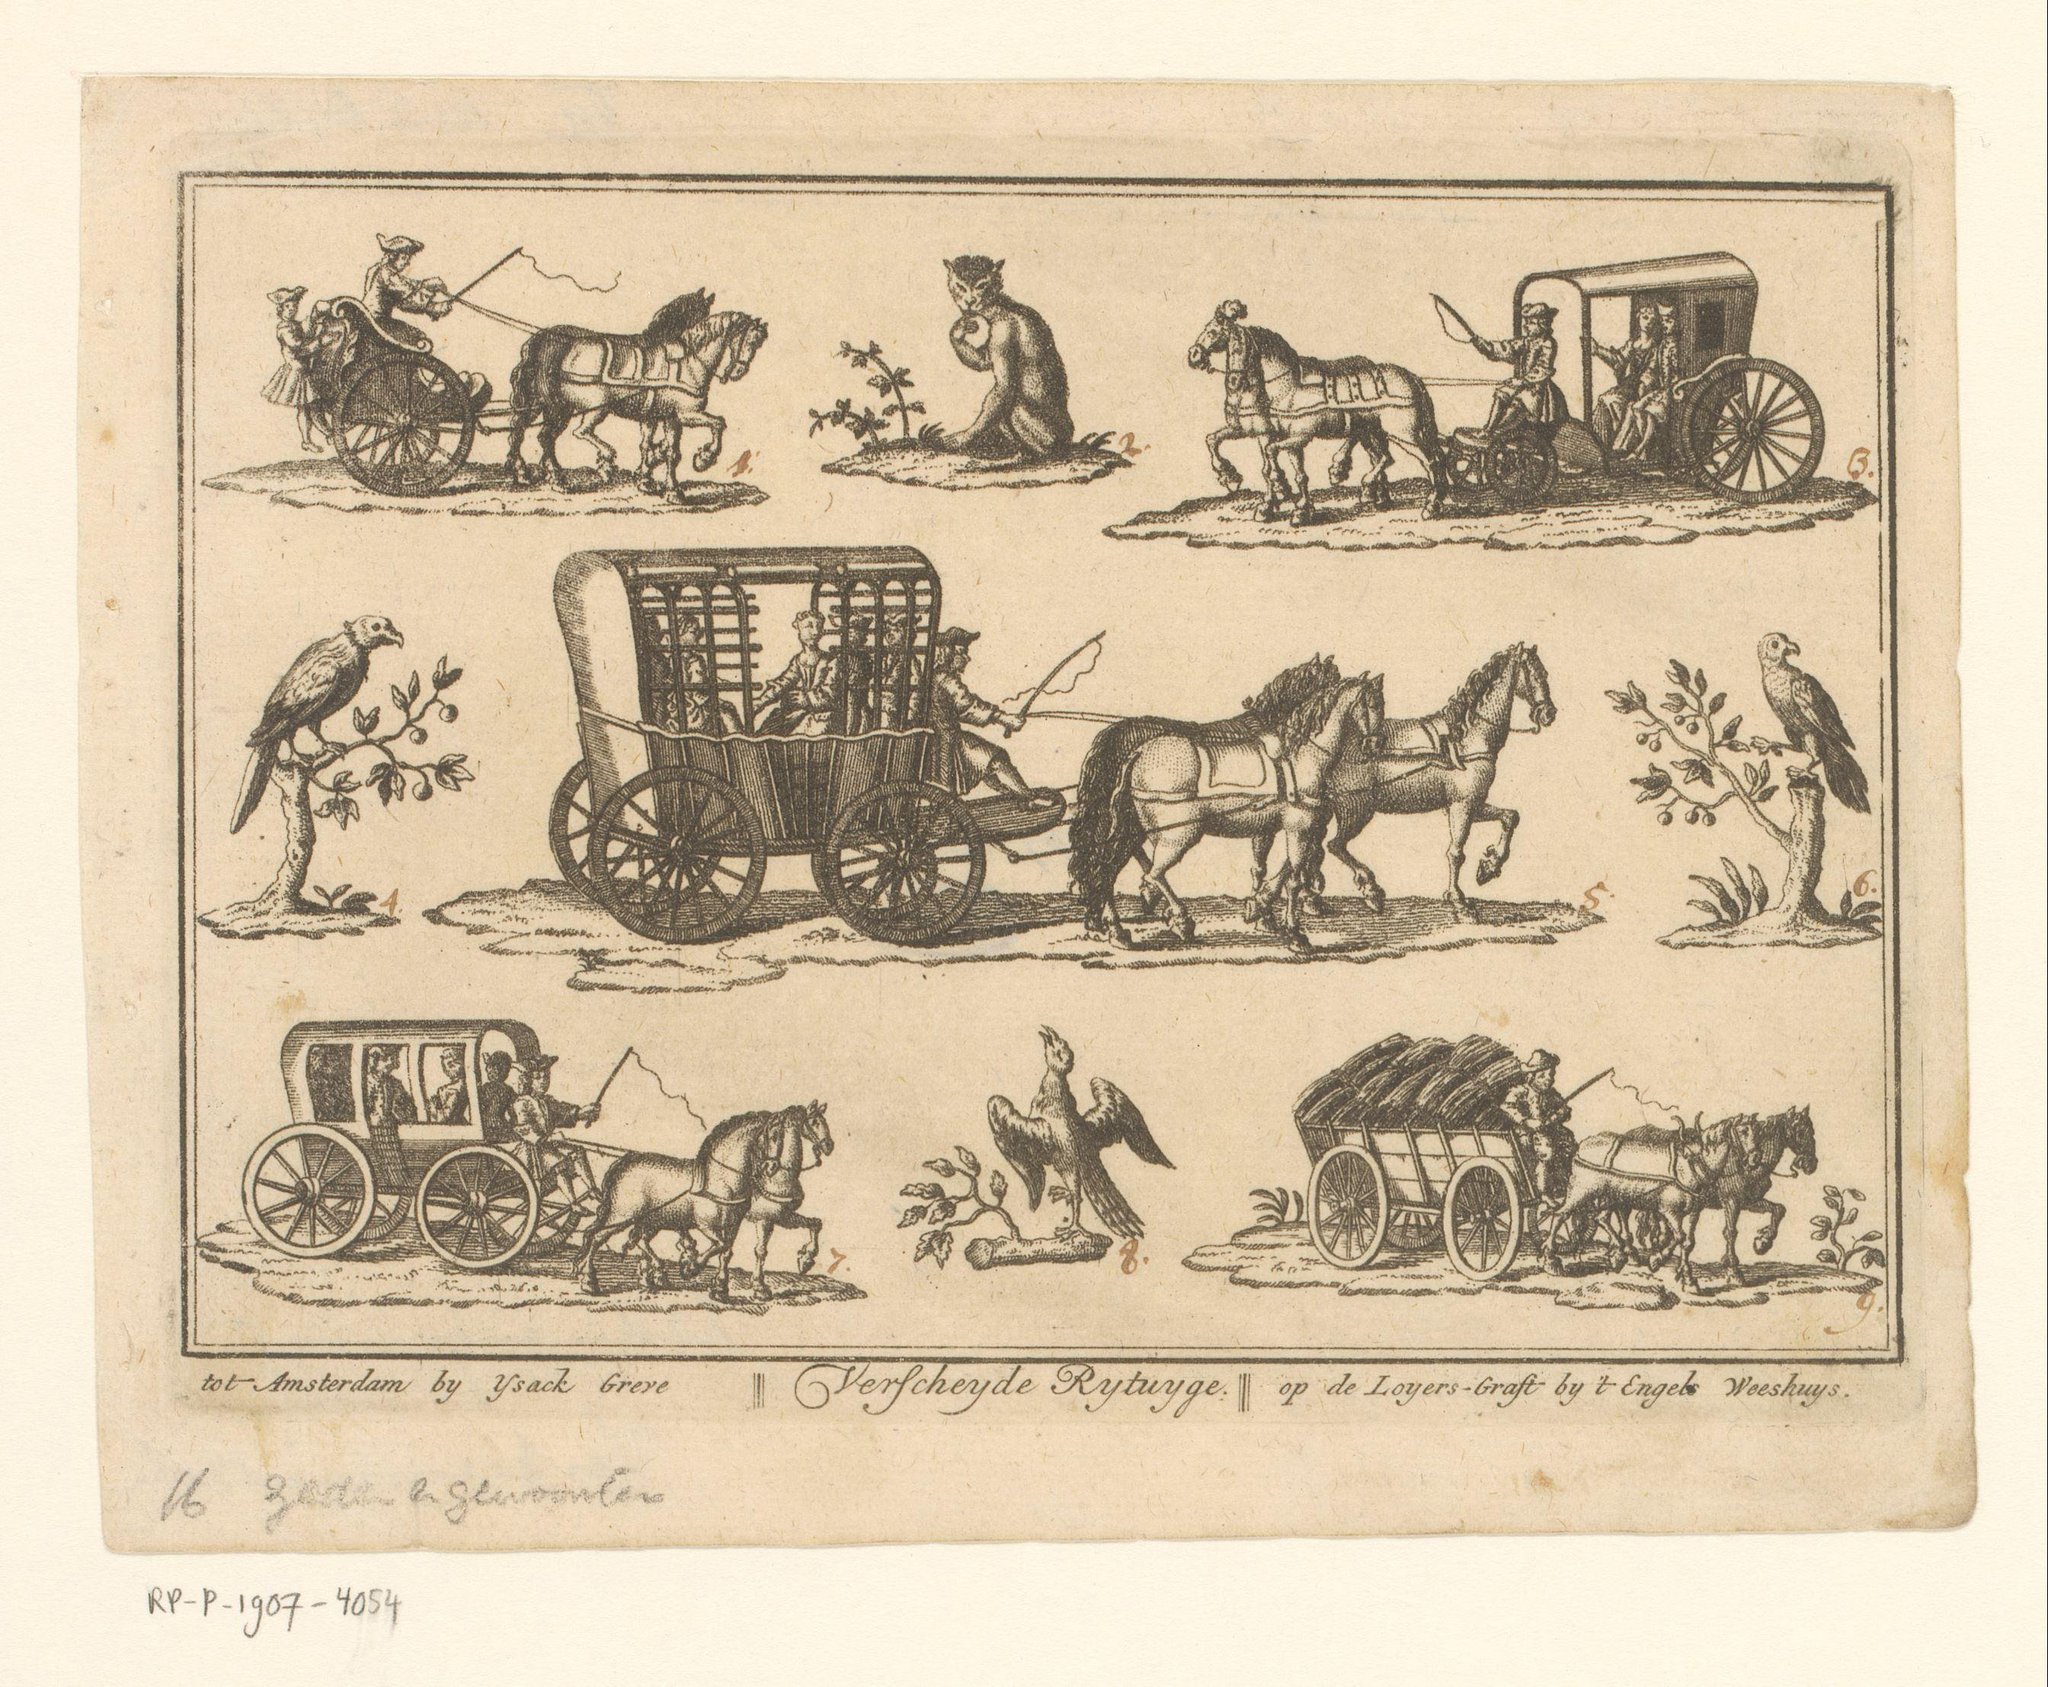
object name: print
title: Verschillende rijtuigen en vogels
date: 1718-1757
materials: paper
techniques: etching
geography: amsterdam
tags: monkeys, apes, birds, covered wagon, hooded wagon, four-wheeled vehicle drawn by two animals, hay-wagon, (farm) wagon, freight wagon, cart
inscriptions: collector's mark: Lugt 2228, number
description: Vijf verschillende paard en wagens, drie vogels op een tak en een aap. De voorstellingen zijn met pen genummerd 1 t/m 9.